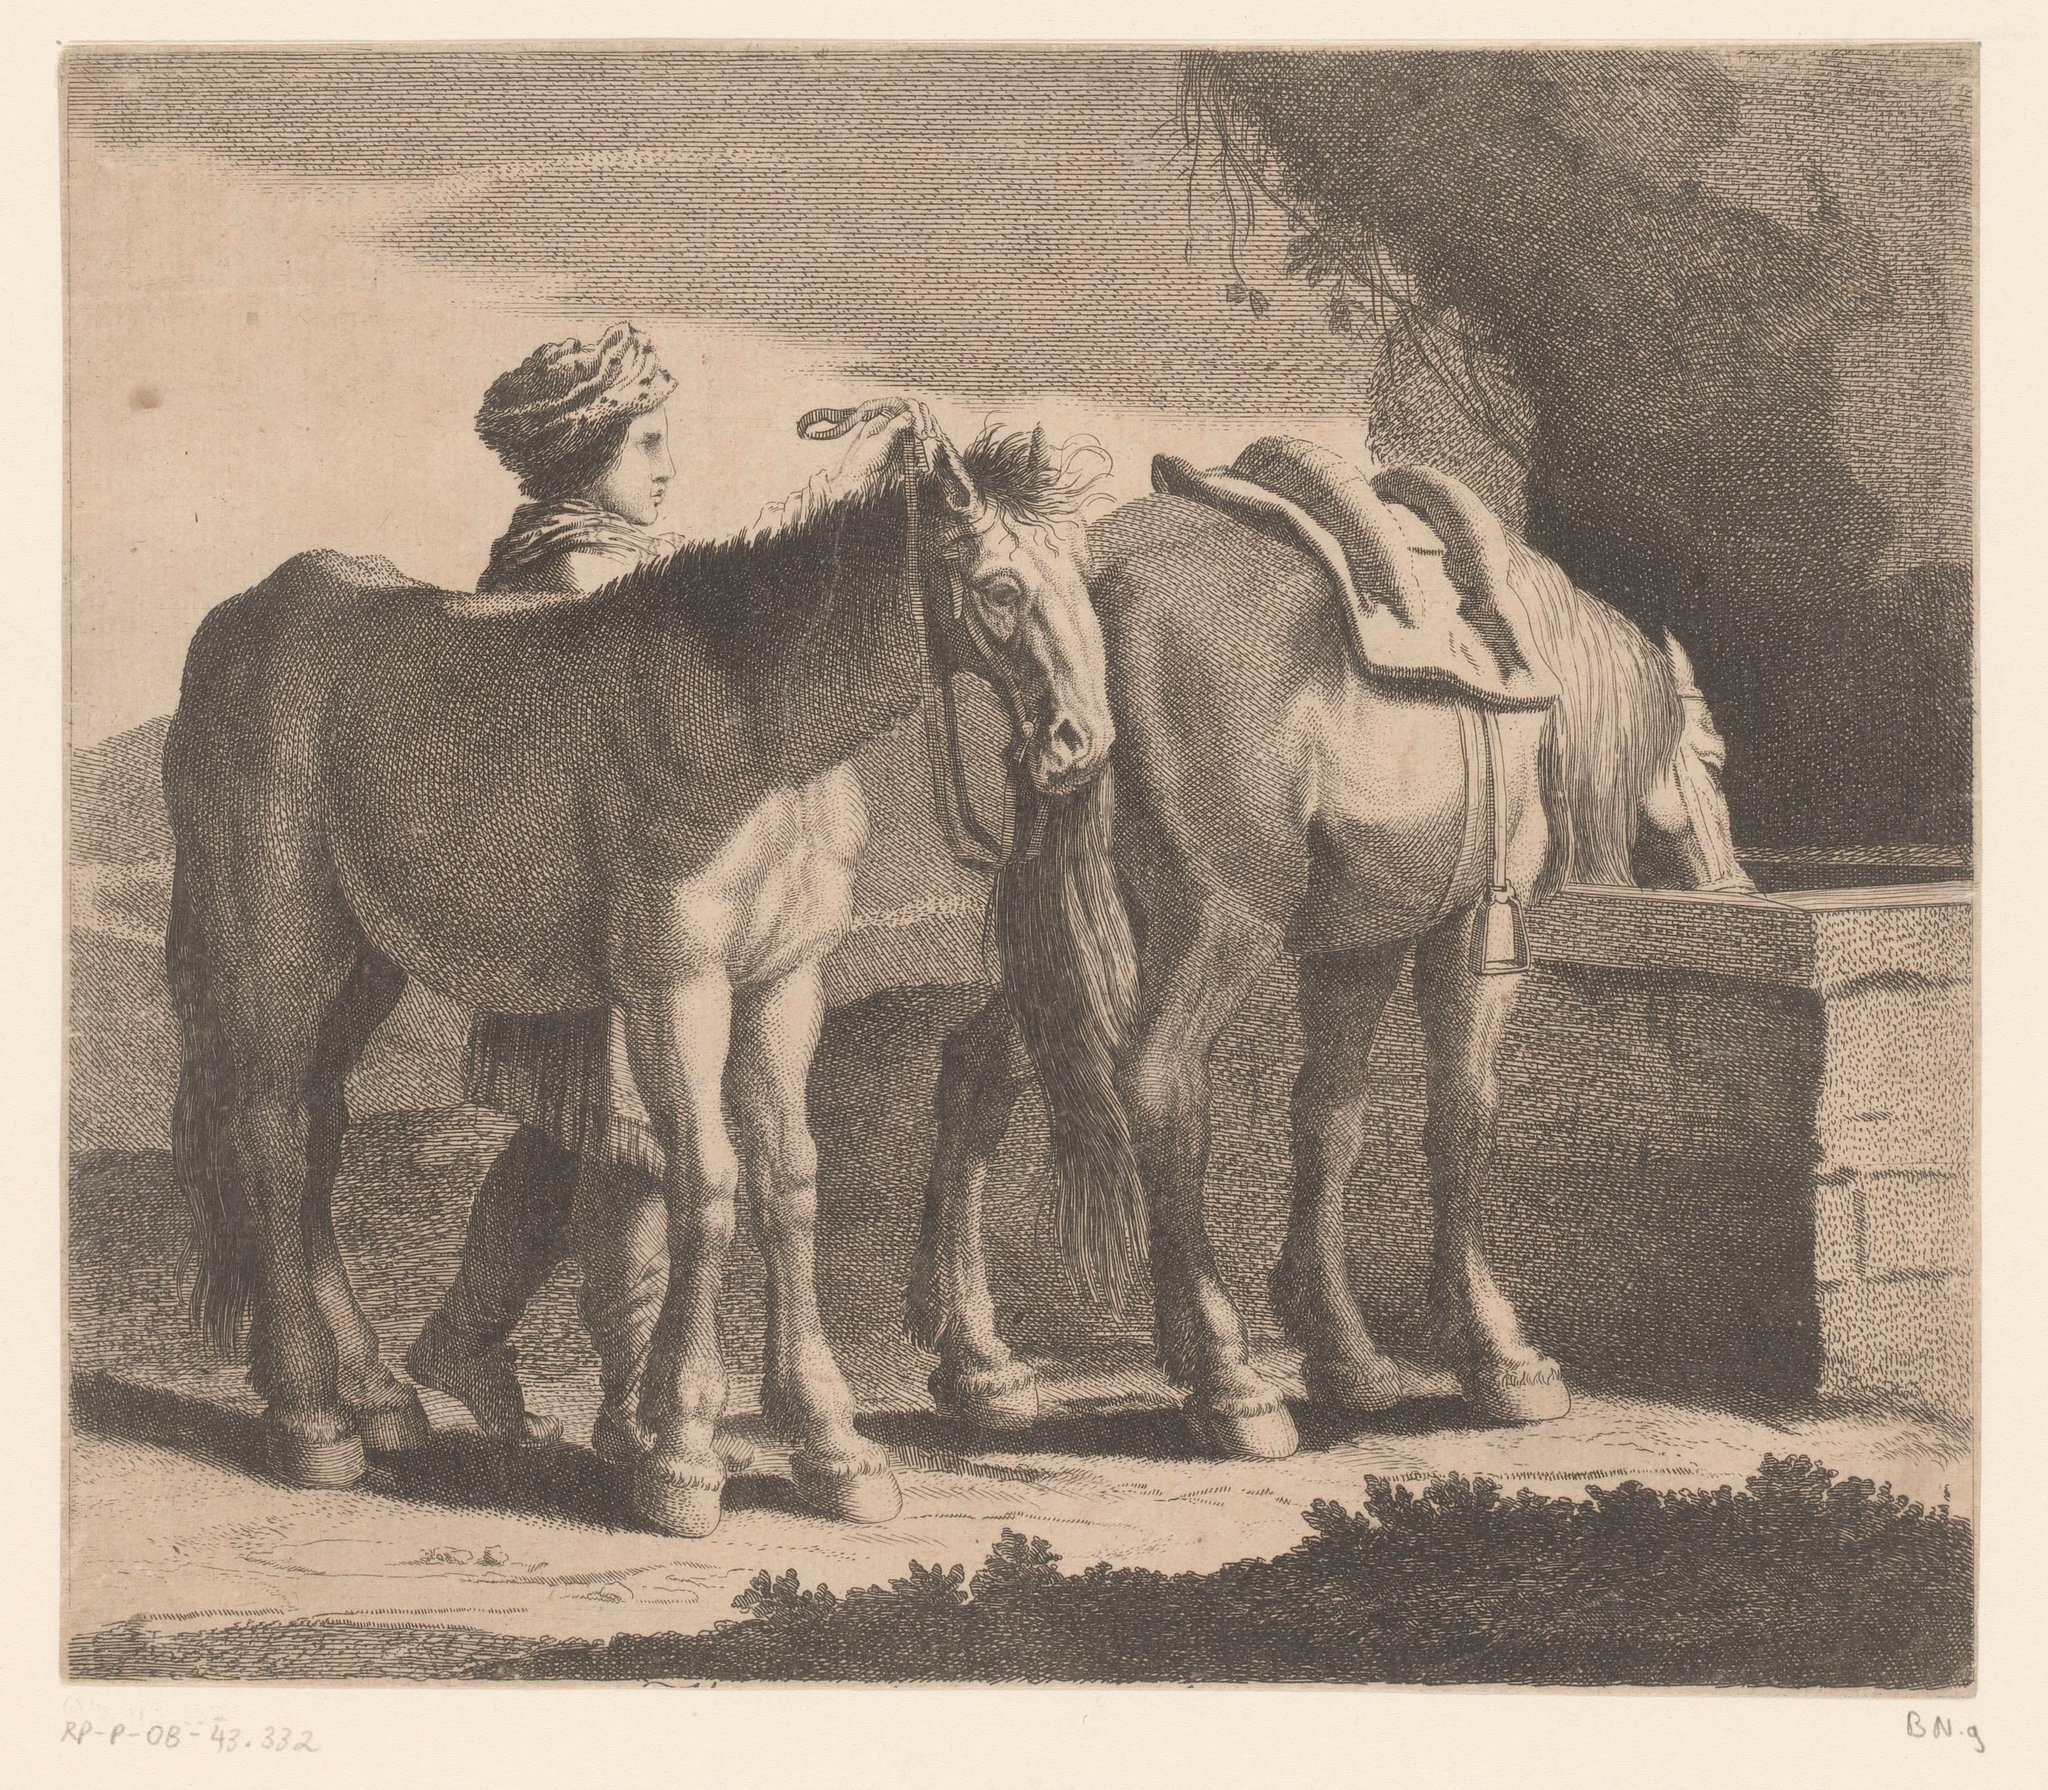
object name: print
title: Masete de Normandie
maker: charles ii errard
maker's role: print maker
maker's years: 1601-1689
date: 1616-1689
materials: paper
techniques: engraving, etching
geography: france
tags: horse, drinking